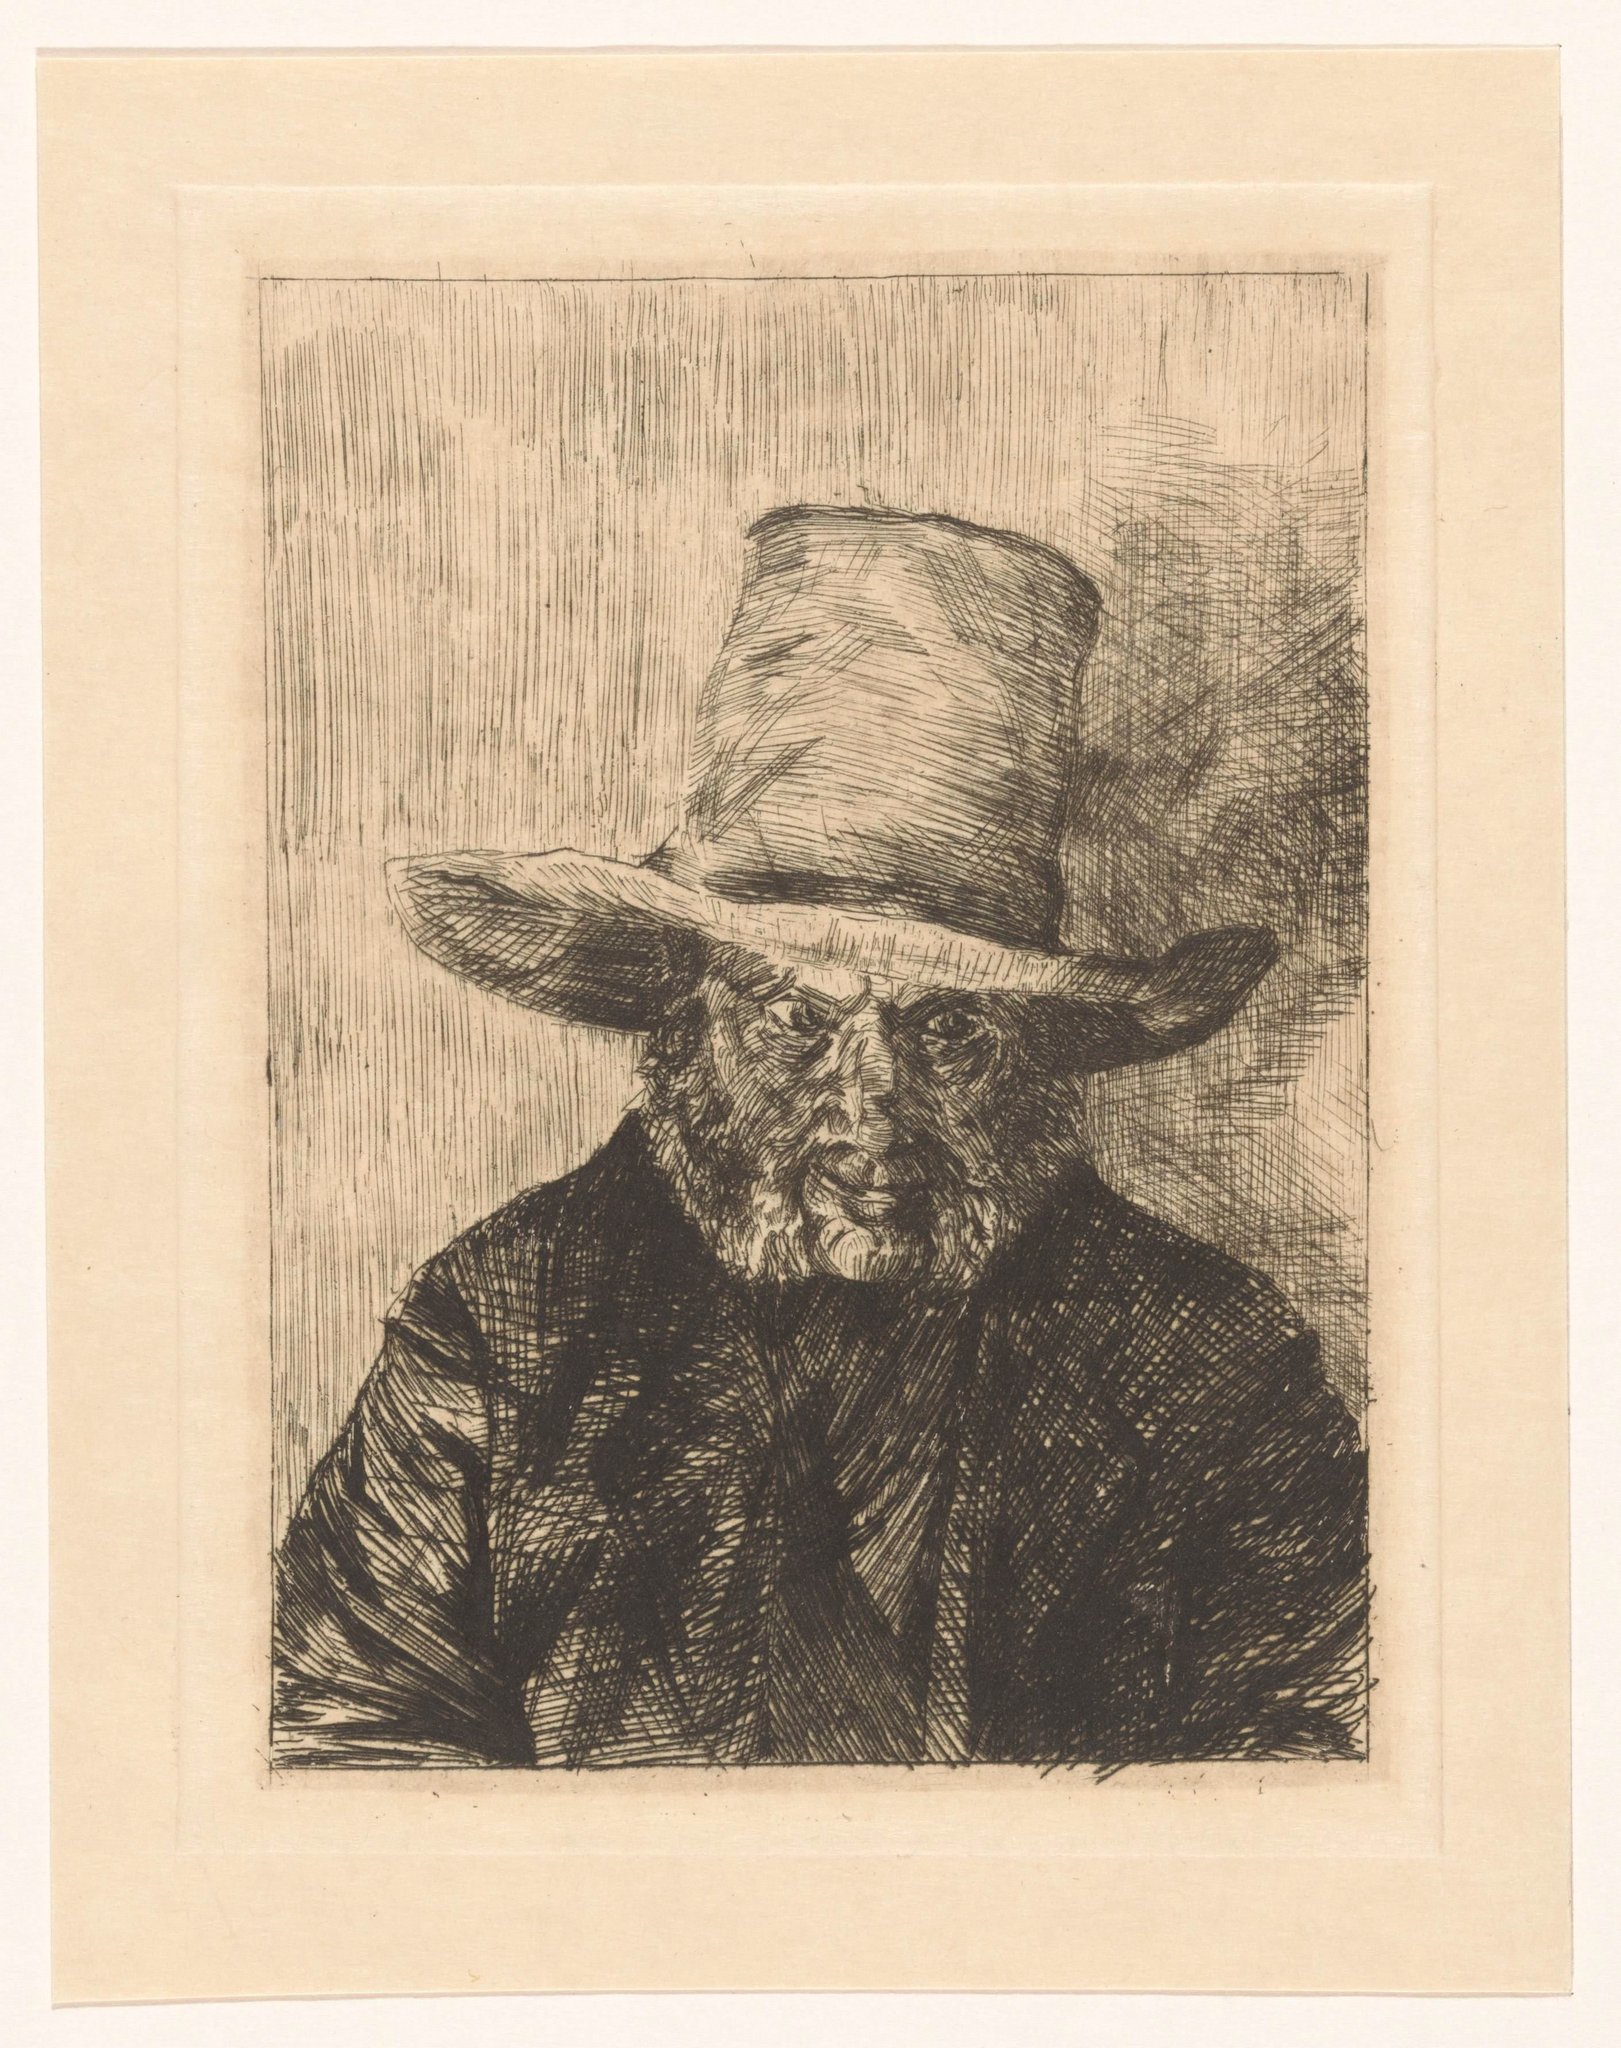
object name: print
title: Portret van een onbekende man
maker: martinus van regteren altena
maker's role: painter, print maker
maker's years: 1866-1908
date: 1876-1908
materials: paper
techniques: etching, intaglio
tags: head-gear: hat (+ men's clothes), anonymous historical person portrayed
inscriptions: collector's mark: Lugt 2228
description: De man draagt een hoed en heeft bakkebaarden.